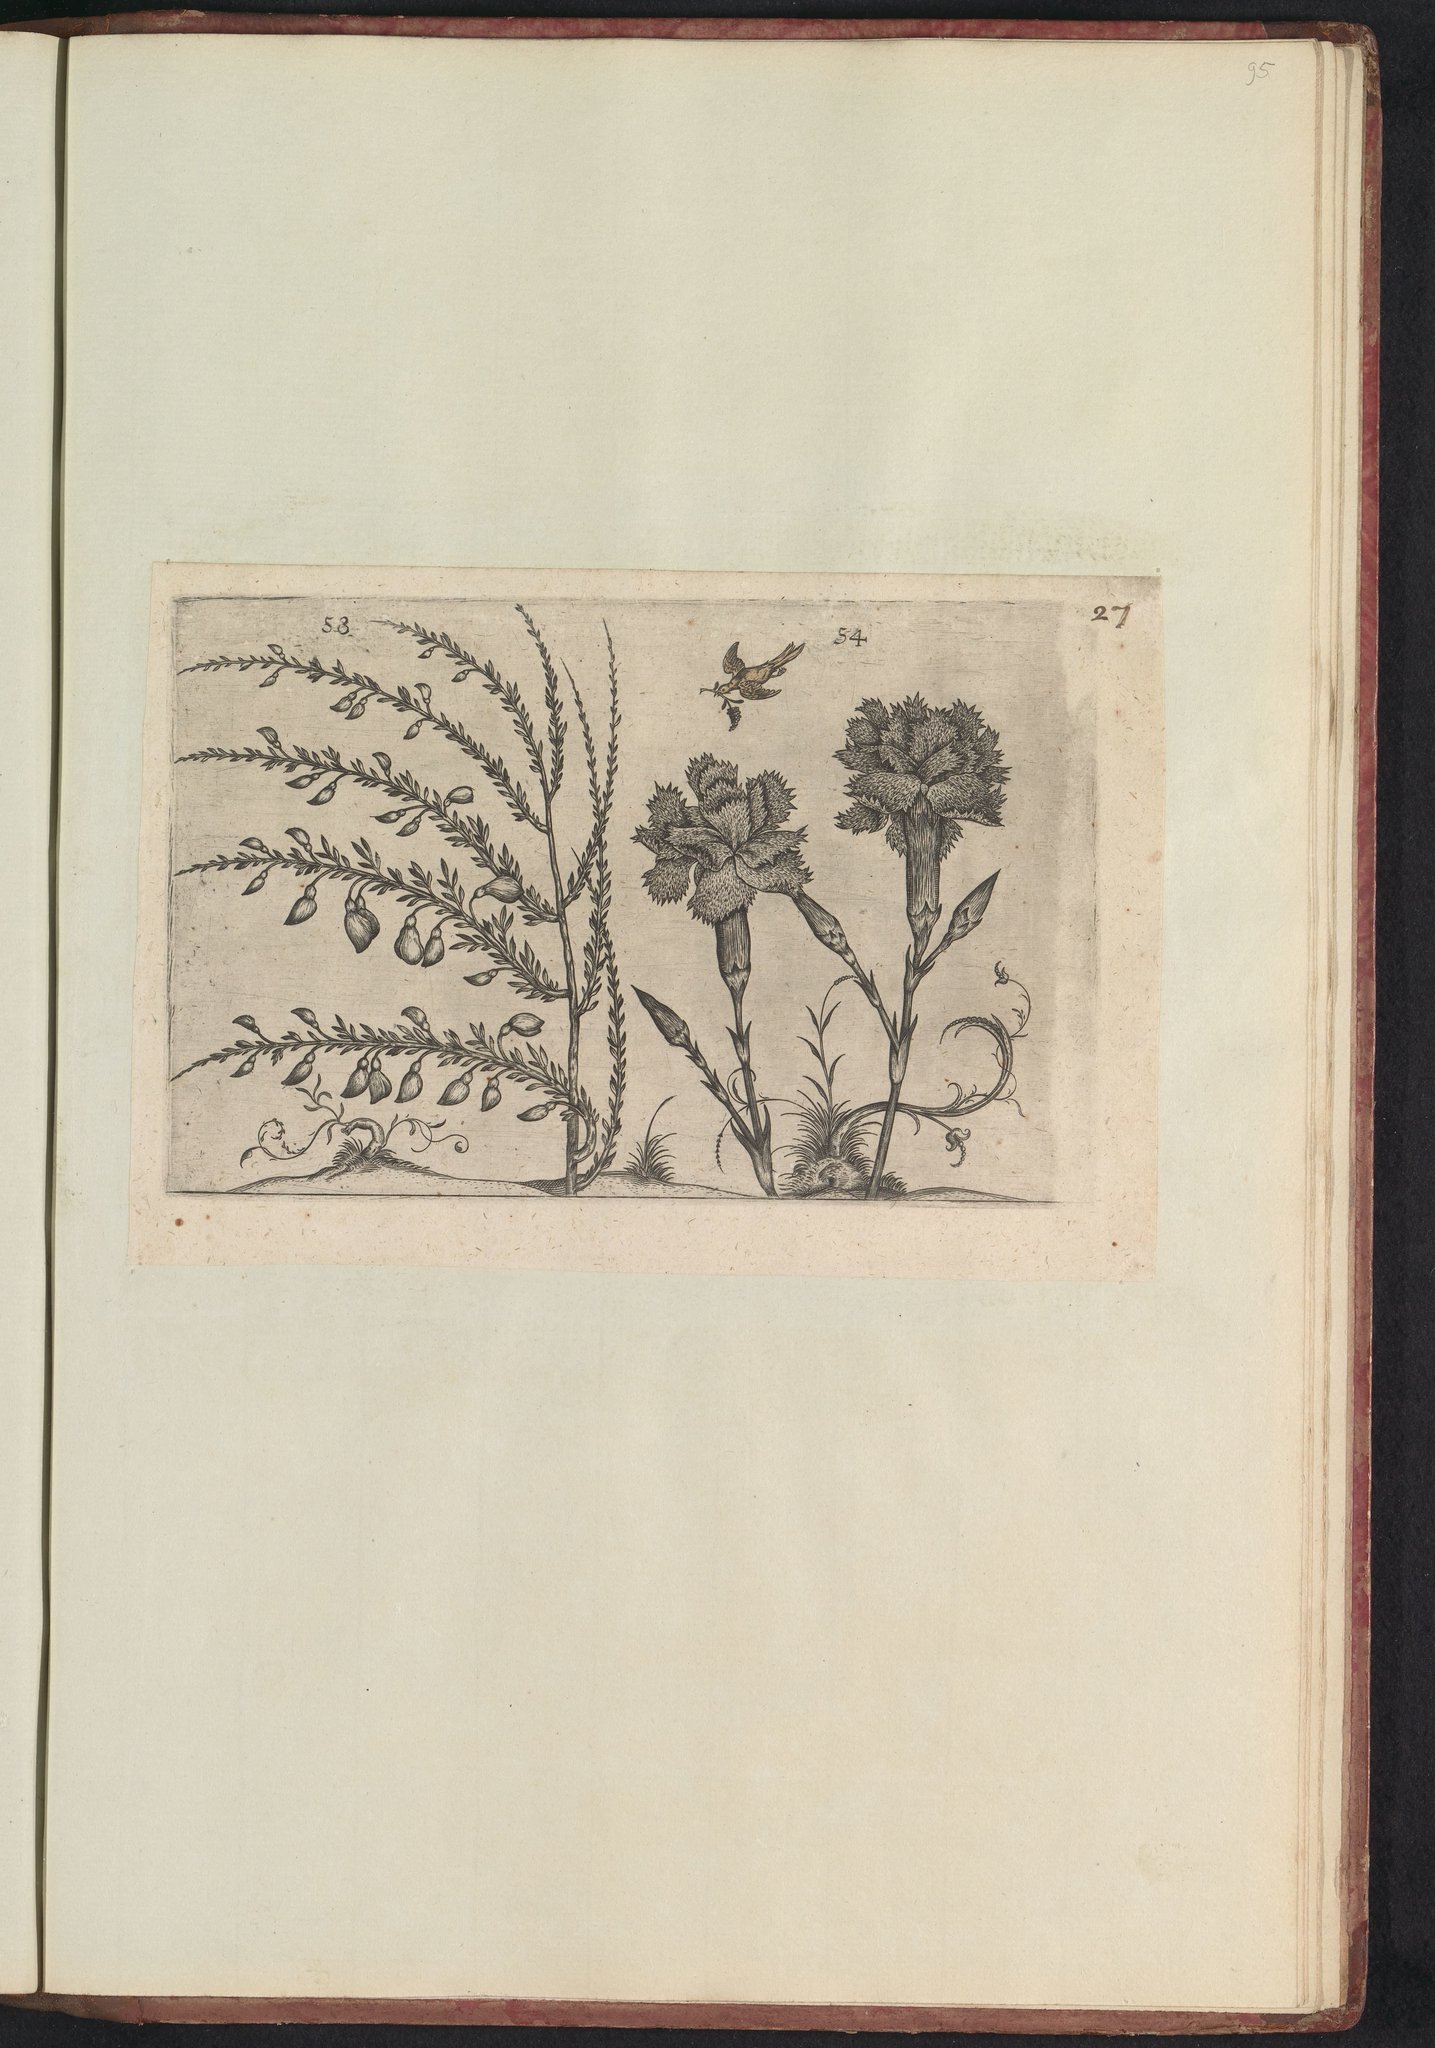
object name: print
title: Tuinanjer (Dianthus caryophyllus) en brem (Cytisus scoparius)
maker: Anonymous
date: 1604-1632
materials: ink, paper, watercolor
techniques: engraving, hand coloring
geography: cologne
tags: flowers: broom, birds, flowers: carnation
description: Tuinanjer en brem. Met een vogel en enkele ornamentele planten. Figs. 53 en 54 op een blad met de hand genummerd 27. In: Anselmi Boëtii de Boot I.C. Brugensis & Rodolphi II. Imp. Roman. medici a cubiculis Florum, Herbarum, ac fructuum selectiorum icones, & vires pleraeque hactenus ignotæ. Onderdeel van het album met bladen en platen uit De Boodts herbarium van 1640. Het twaalfde van twaalf albums met aquarellen van dieren, vogels en planten bekend rond 1600, gemaakt in opdracht van keizer Rudolf II.